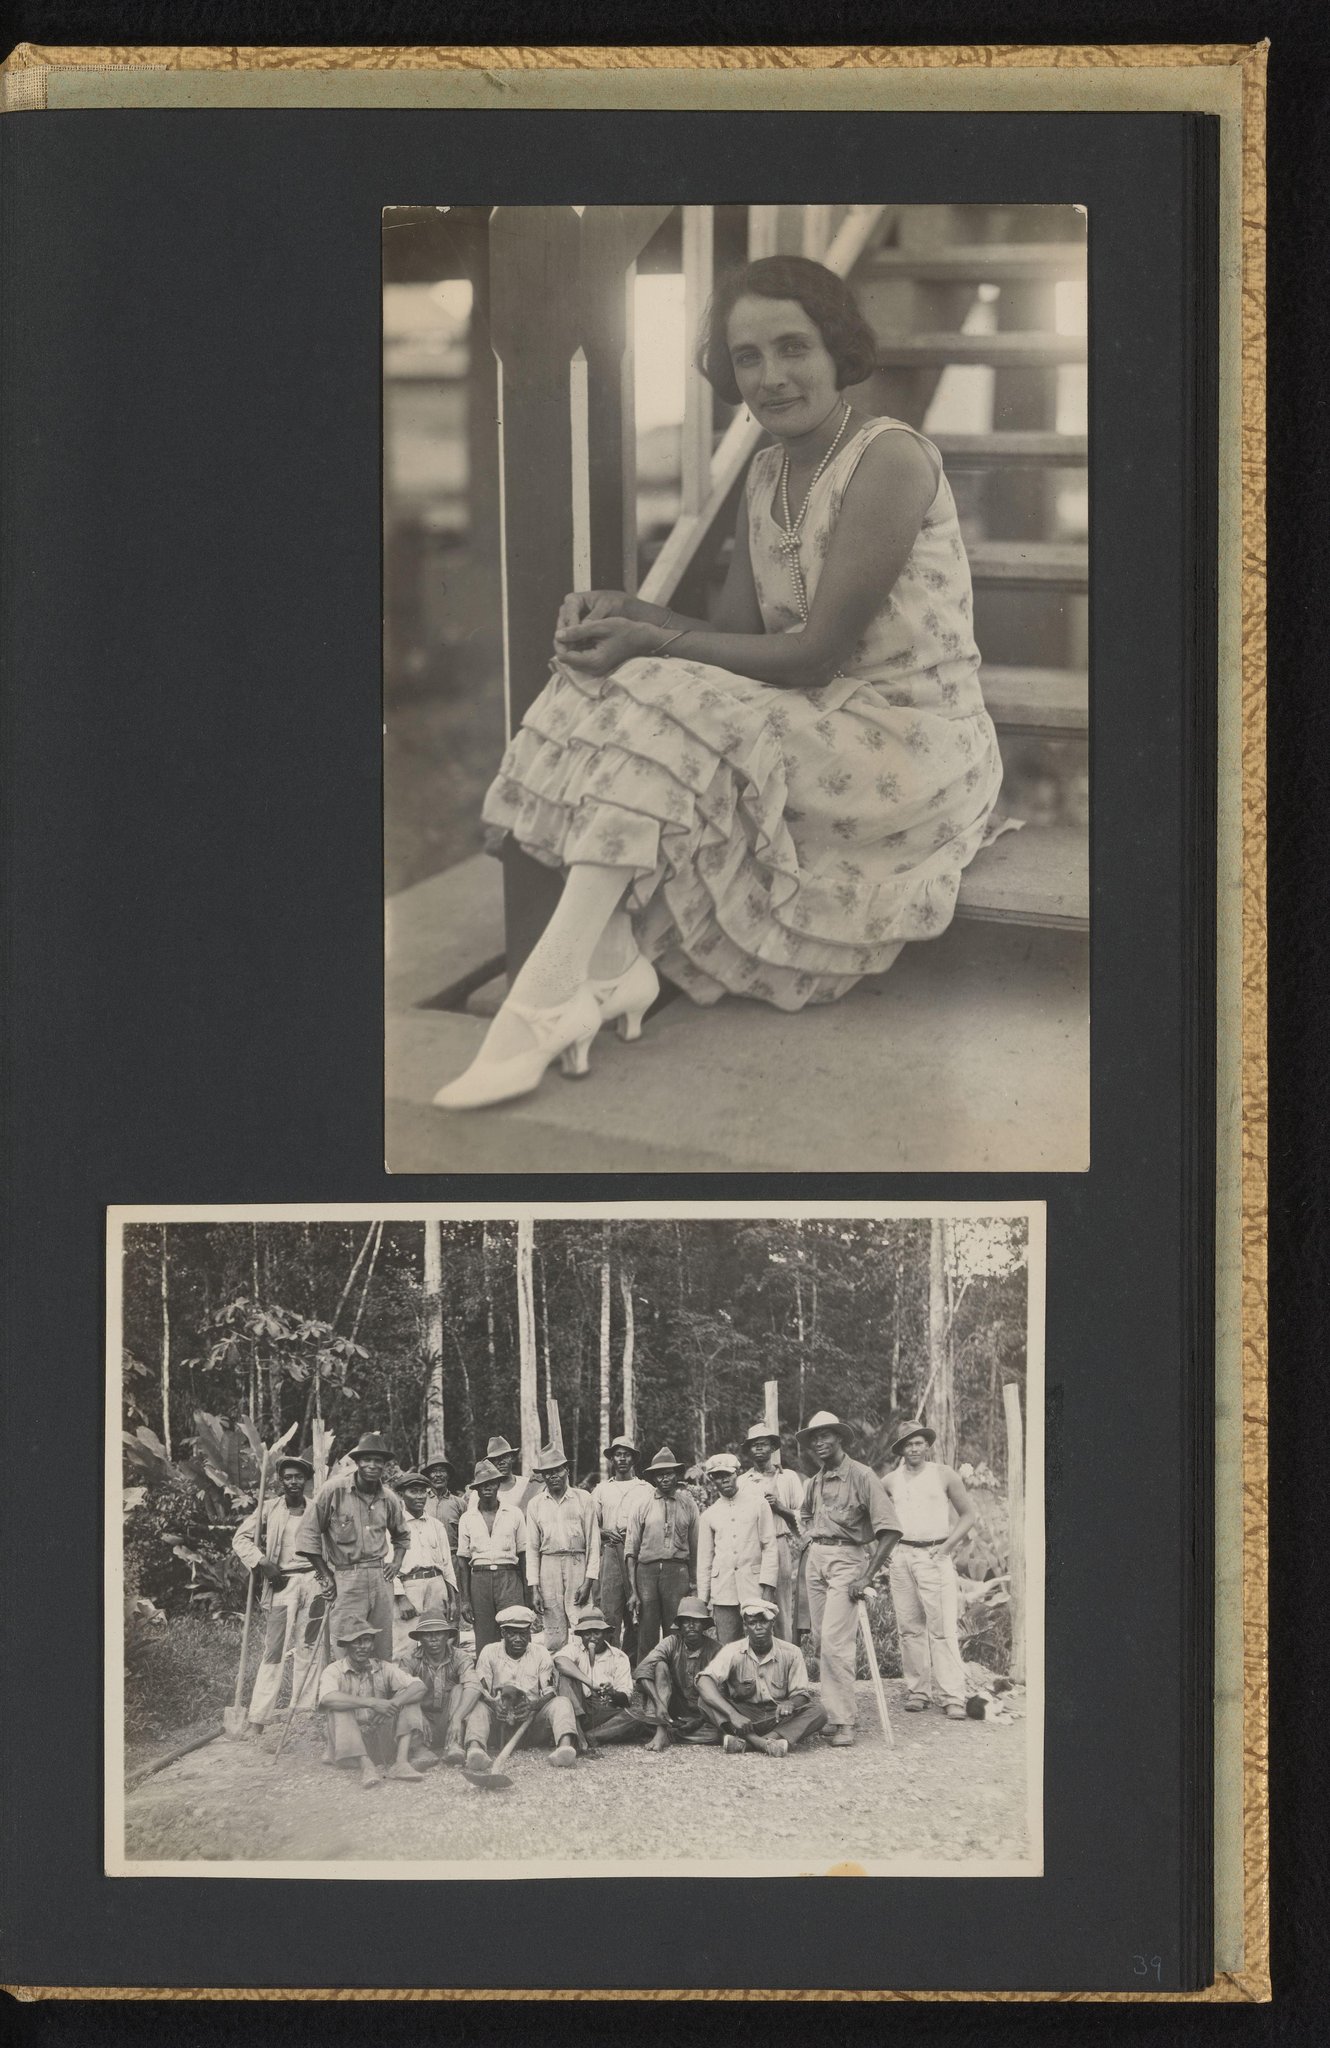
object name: photograph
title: Portret van een jonge vrouw en groepsfoto van werknemers in Moengo, Suriname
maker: Anonymous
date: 1927-1931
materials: paper, photographic support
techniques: gelatin silver print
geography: suriname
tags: historical persons - bb - woman, working class, labourers, suriname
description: Albumblad met twee foto's. Op de bovenste foto poseert een jonge Nederlandse vrouw (mrs. de Koning, secretaresse op het bedrijfskantoor in Paramaribo en een kennis van de familie Guilonard) in feestjurk zittend op een trap. Op de onderste foto poseert een groep Surinaamse werknemers in het bos bij Moengo. Onderdeel van het album van de familie Guilonard over de bauxietwinning in Moengo en Albina in Suriname in de jaren 1929-1930.